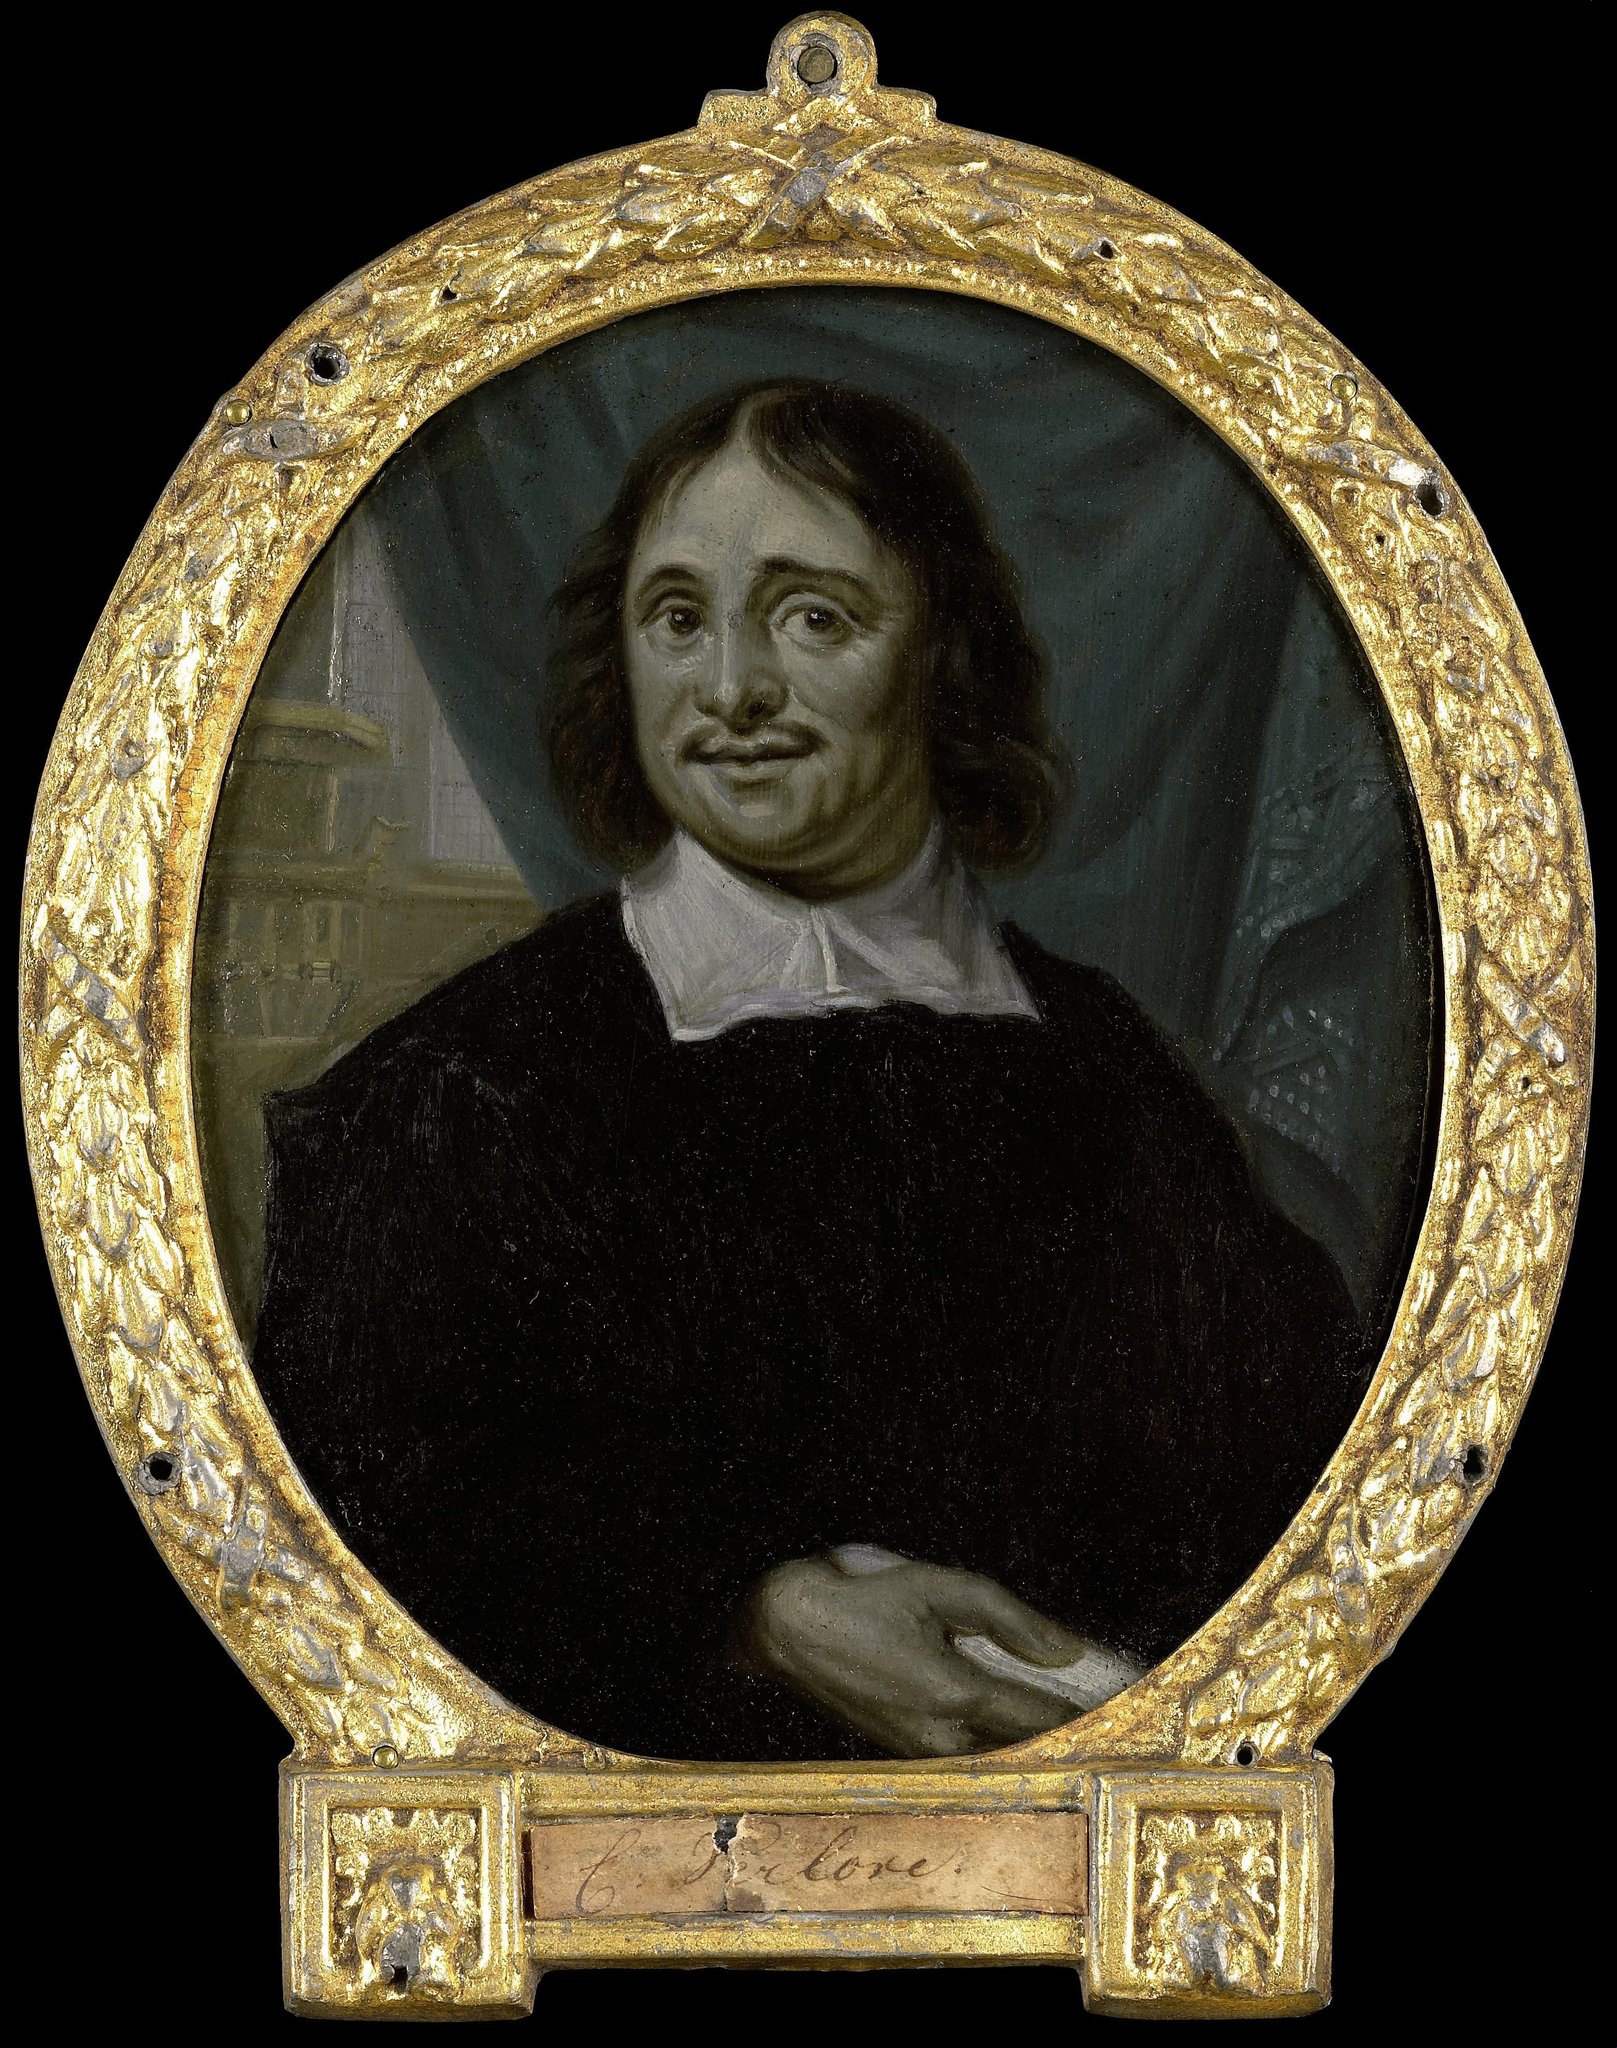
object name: grisaille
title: Portrait of Karel Verloove, Poet in Amsterdam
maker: arnoud van halen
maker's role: draughtsman, painter, print maker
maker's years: 1673-1732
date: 1700-1732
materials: oil, metal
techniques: grisaille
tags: portrait of a writer, writer, poet, author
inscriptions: inscription: ‘Carel Verlove. 1633’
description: Portret van Karel Verloove (1633-na 1695), dichter te Amsterdam. Buste in ovaal, het hoofd iets naar links. Op de achtergrond een kerkinterieur met preekstoel. Vervaardigd naar een onbekend voorbeeld. Onderdeel van een verzameling portretten van Nederlandse dichters.